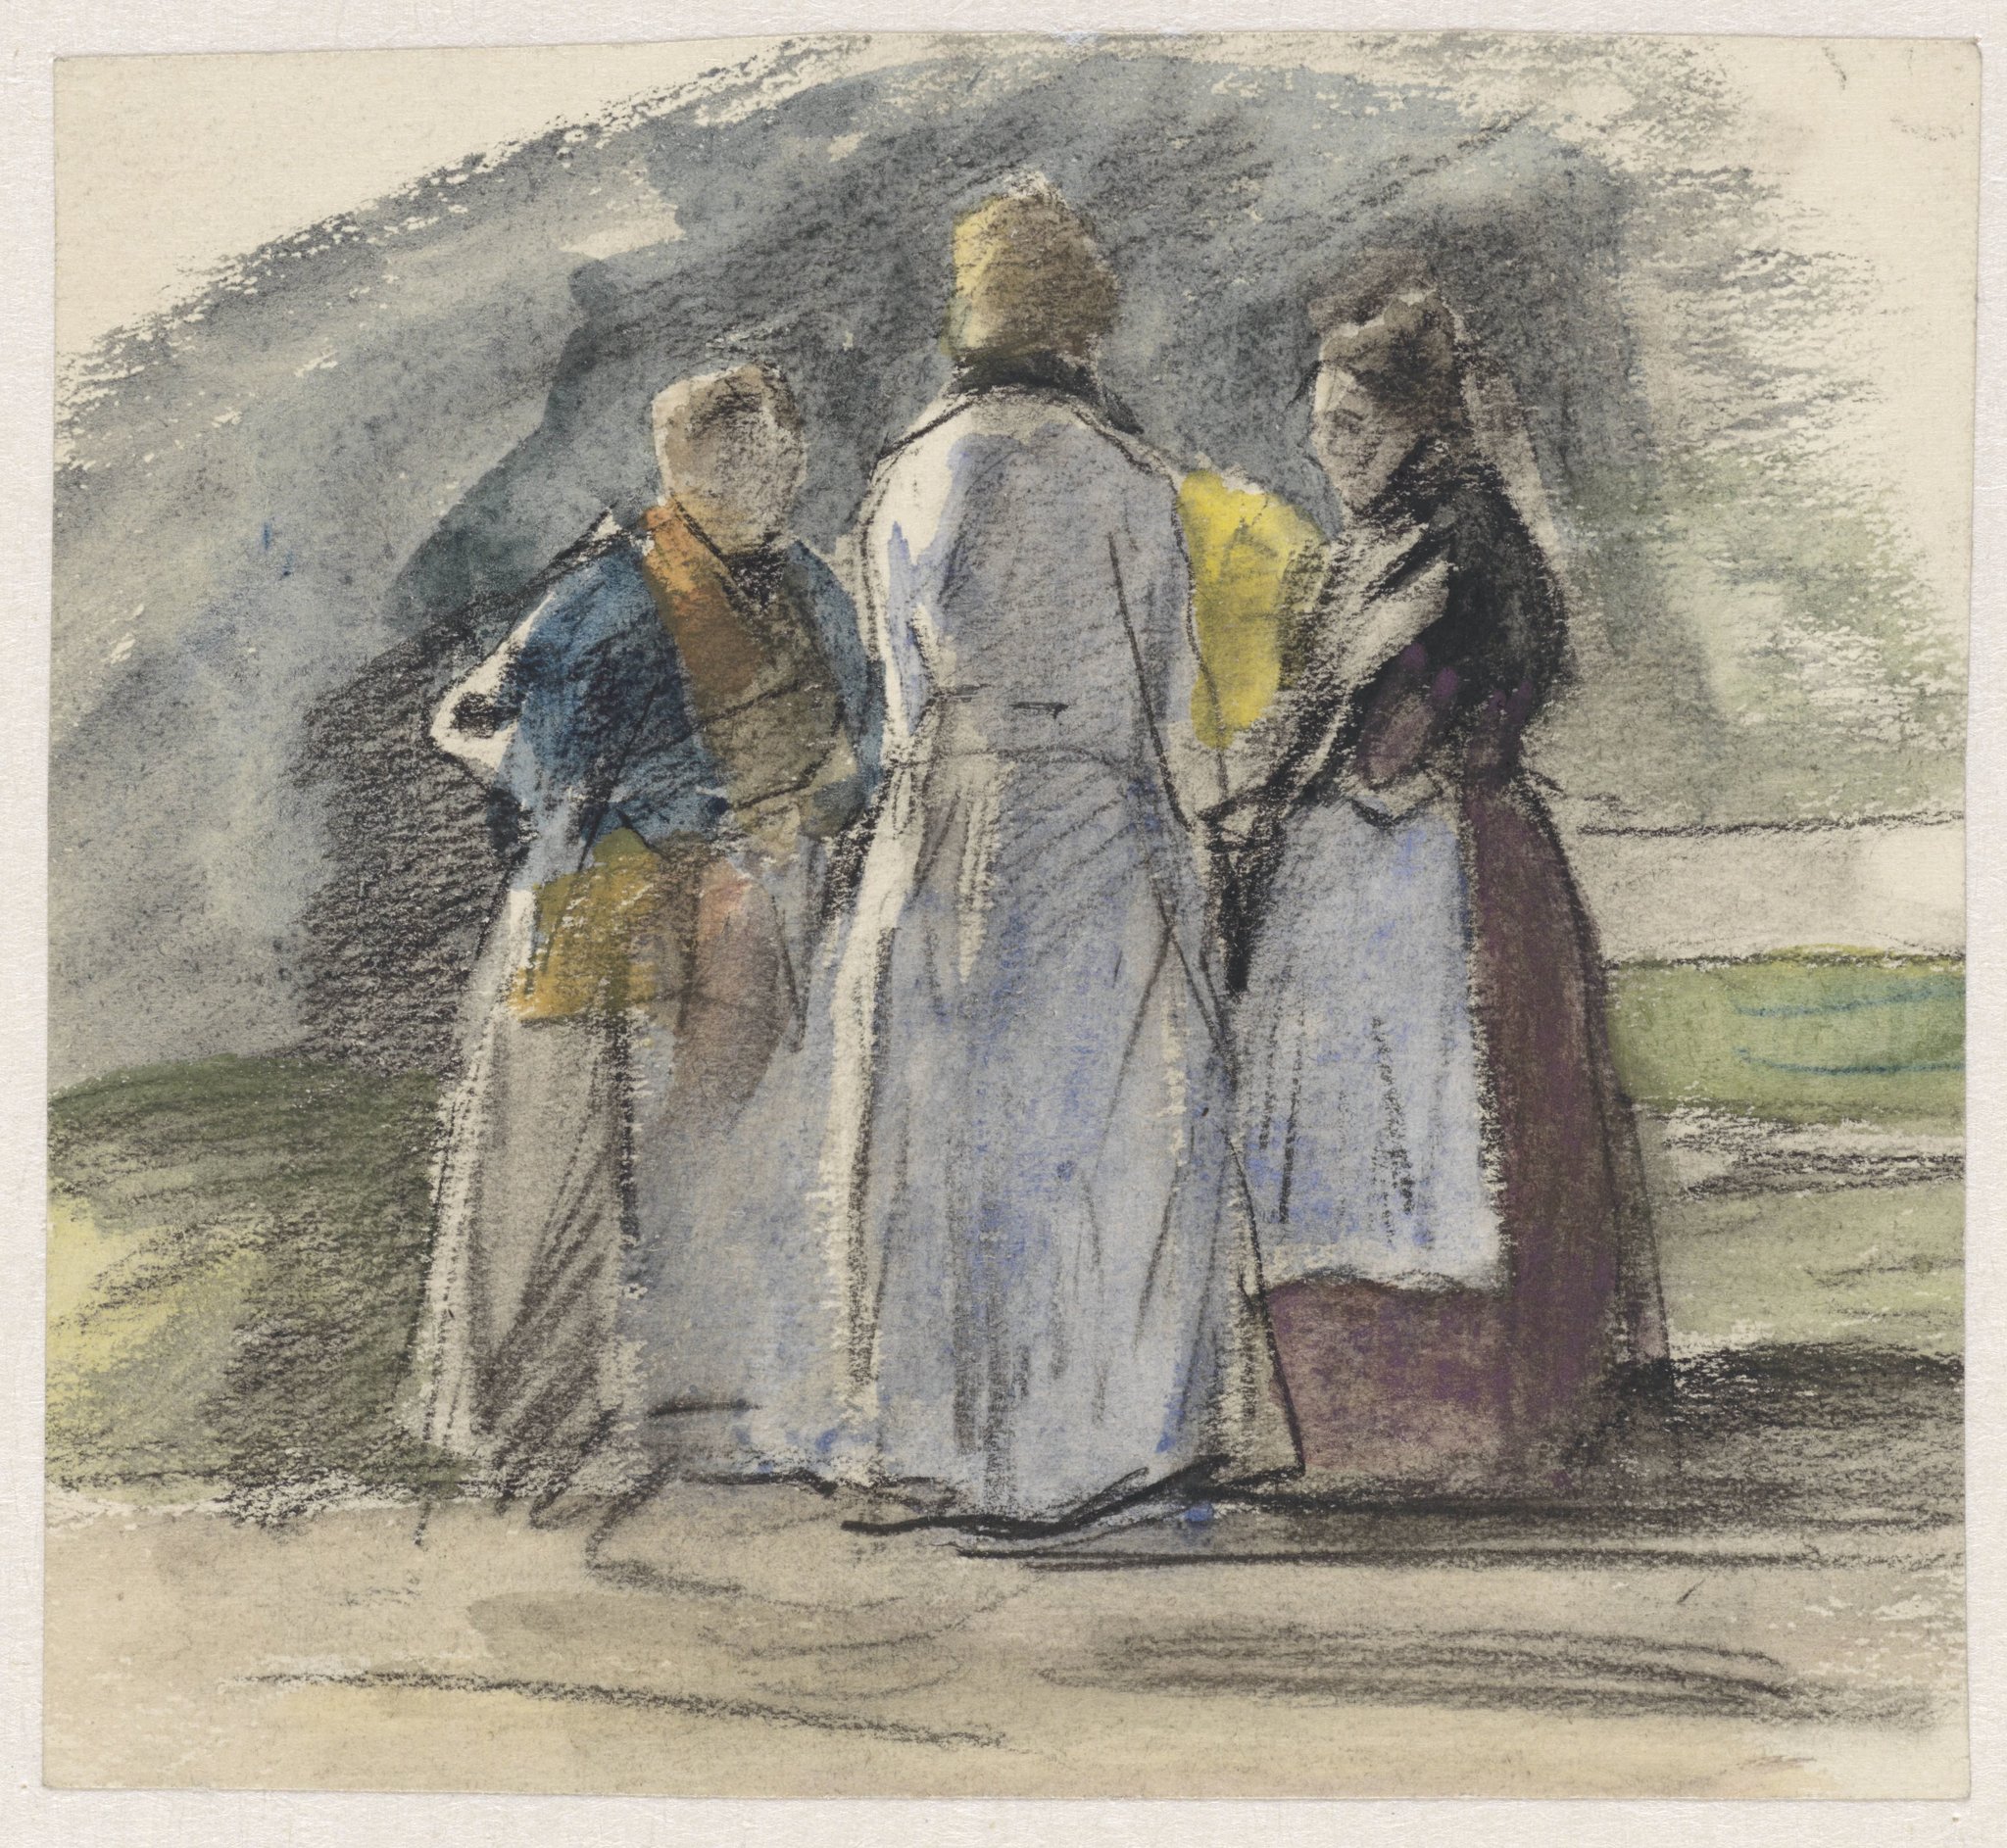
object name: drawing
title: Drie staande vrouwen in gesprek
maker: johan antonie de jonge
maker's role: draughtsman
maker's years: 1864-1927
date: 1874-1927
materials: chalk, paper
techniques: brush